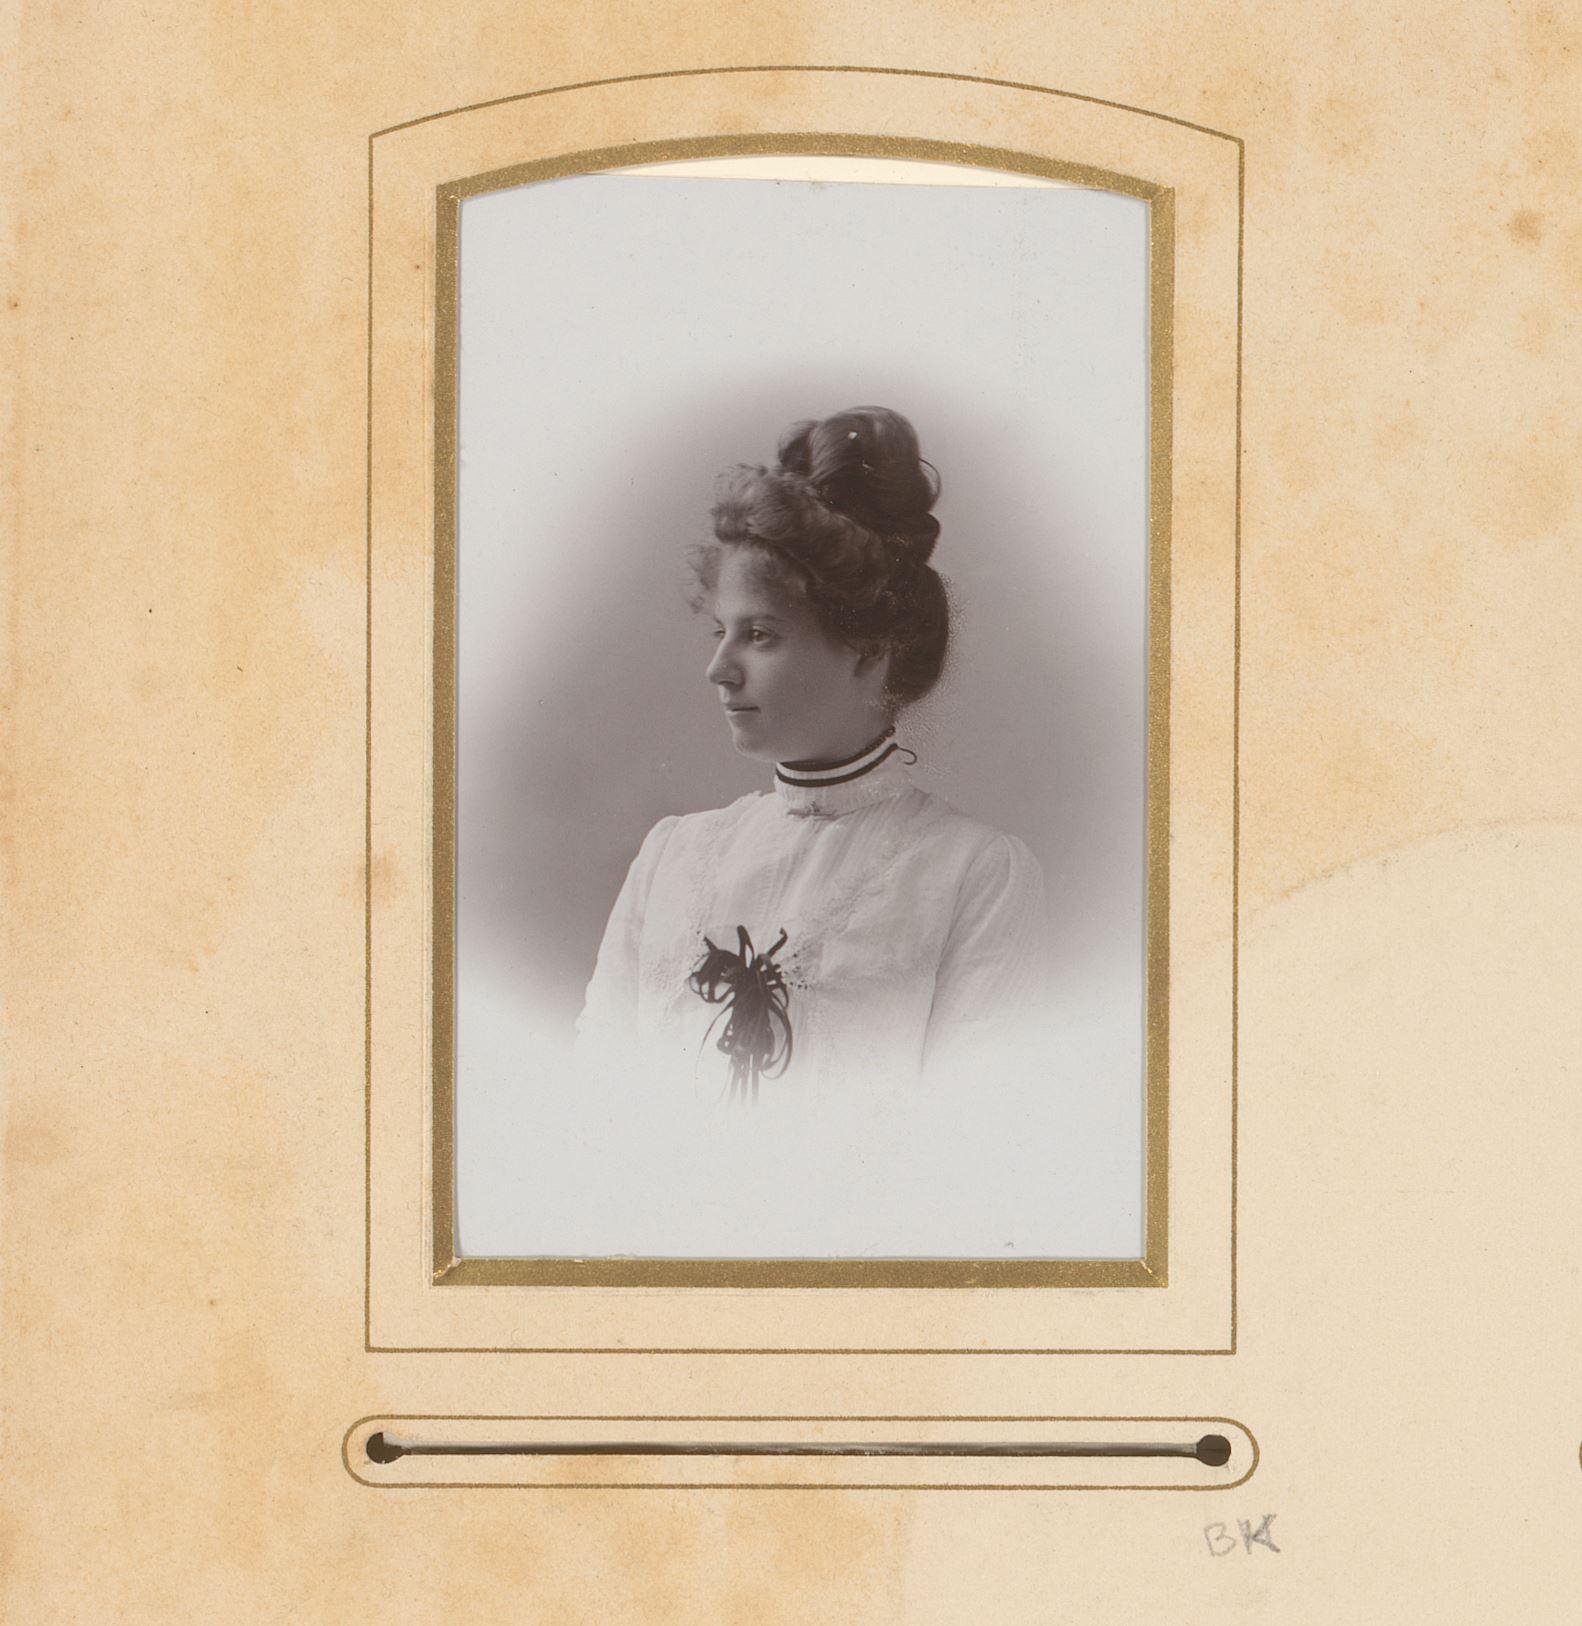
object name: album leaf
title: Portret van een jonge vrouw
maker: christian beitz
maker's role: fotograaf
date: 1880-1920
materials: cardboard, photographic support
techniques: collodion silver print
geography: arnstadt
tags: adolescent, young woman, maiden, historical persons - bb - woman